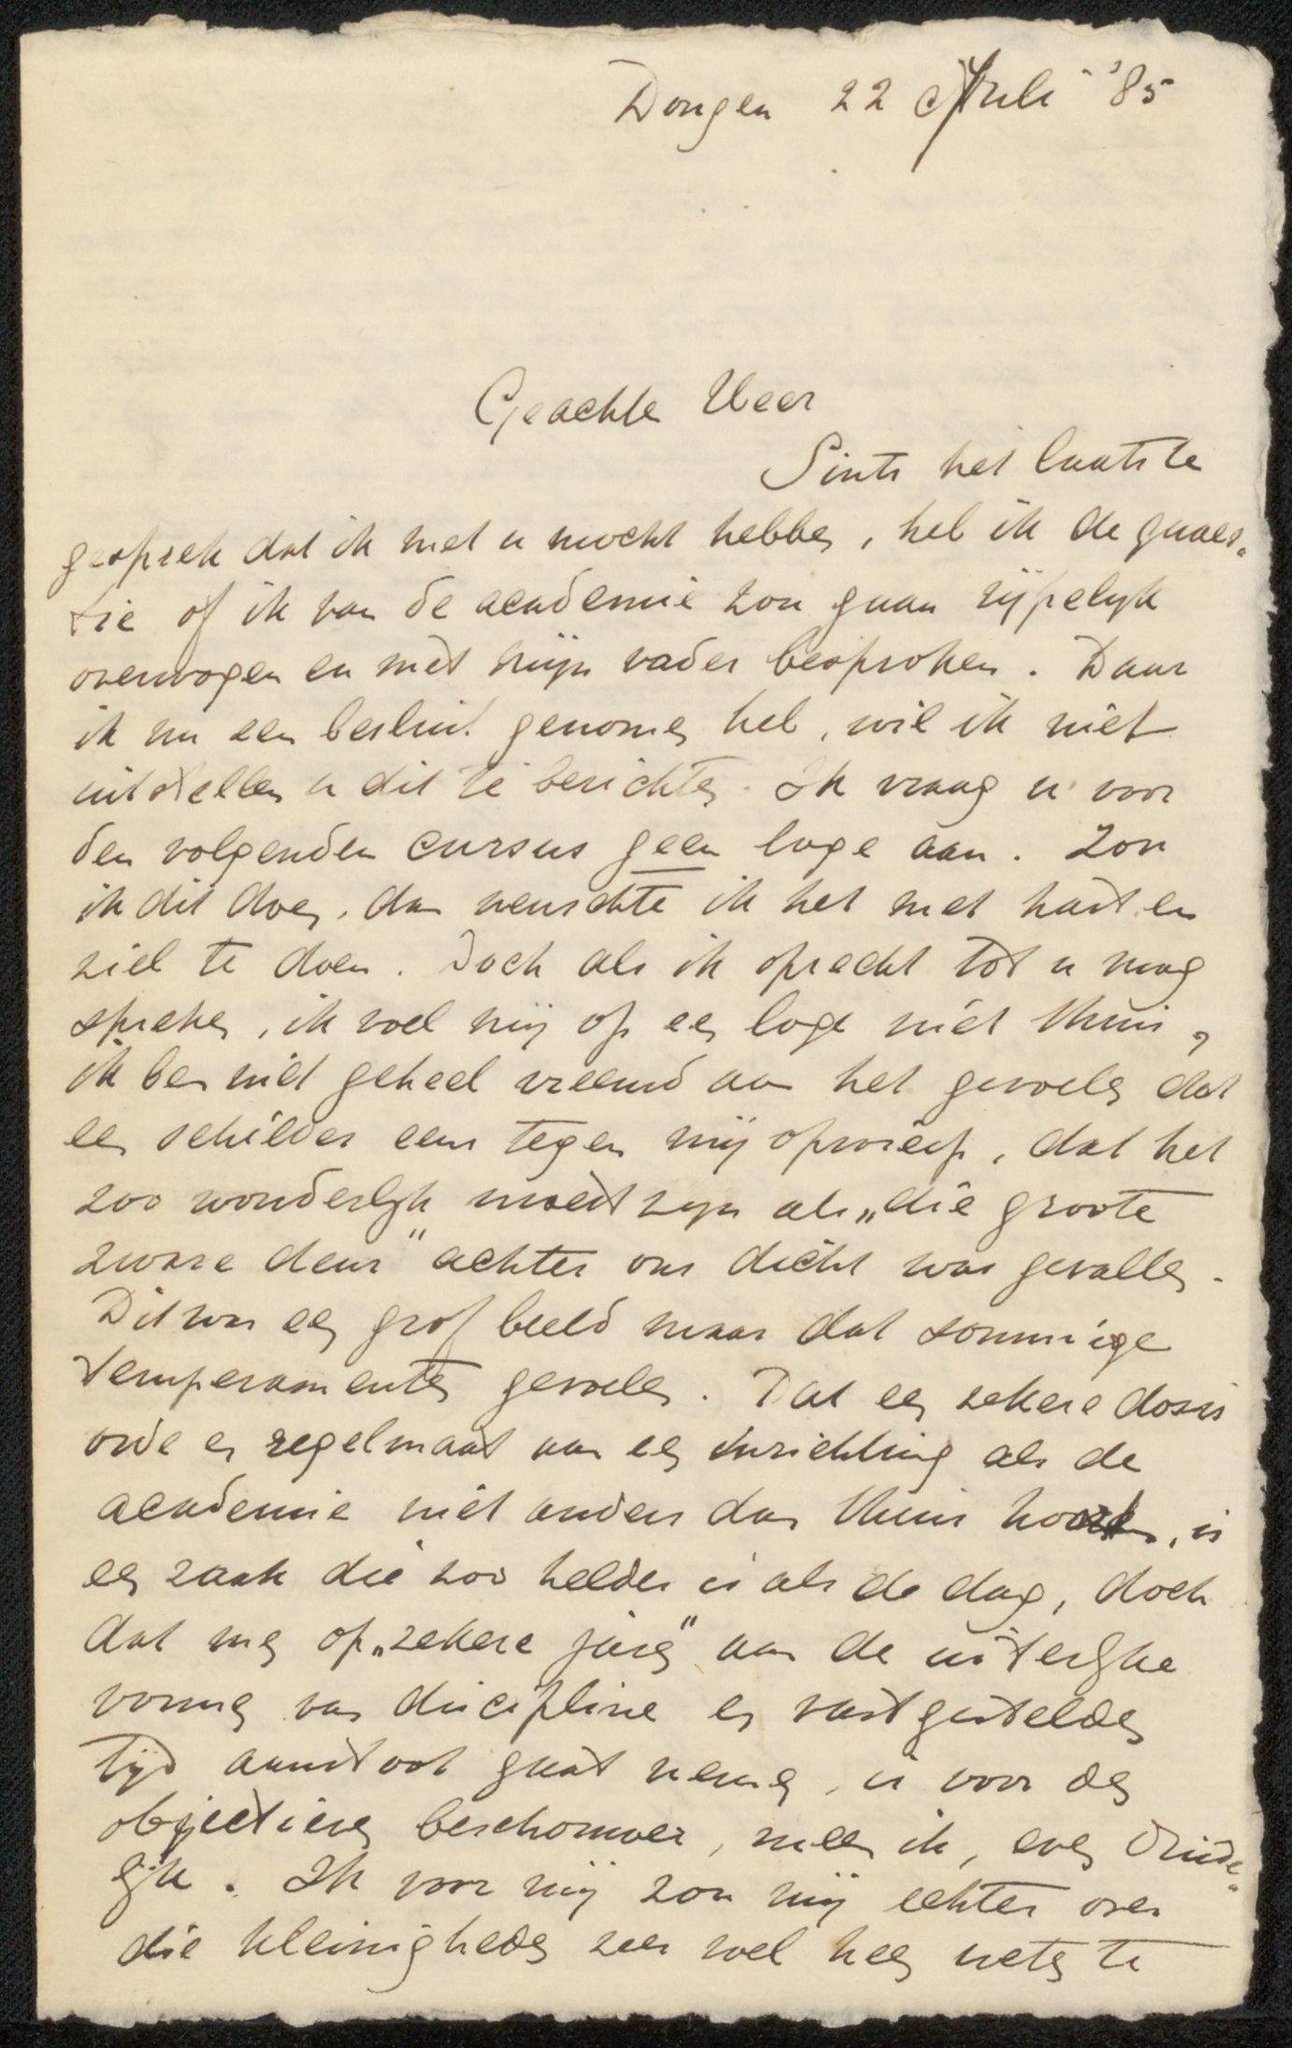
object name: letter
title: Brief aan August Allebé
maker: jan veth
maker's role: designer, draughtsman, painter, print maker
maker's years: 1864-1925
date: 1885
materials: ink, paper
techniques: pen, writing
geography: dongen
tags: august allebé, willem witsen, haarlem, painter, print maker, draughtsman, jac van looij, frederik van eeden, distribution of awards ~ art contest, painting (including book-illumination, miniature-painting), historical persons (portraits and scenes from the life)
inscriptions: collector's mark: ‘RPK’